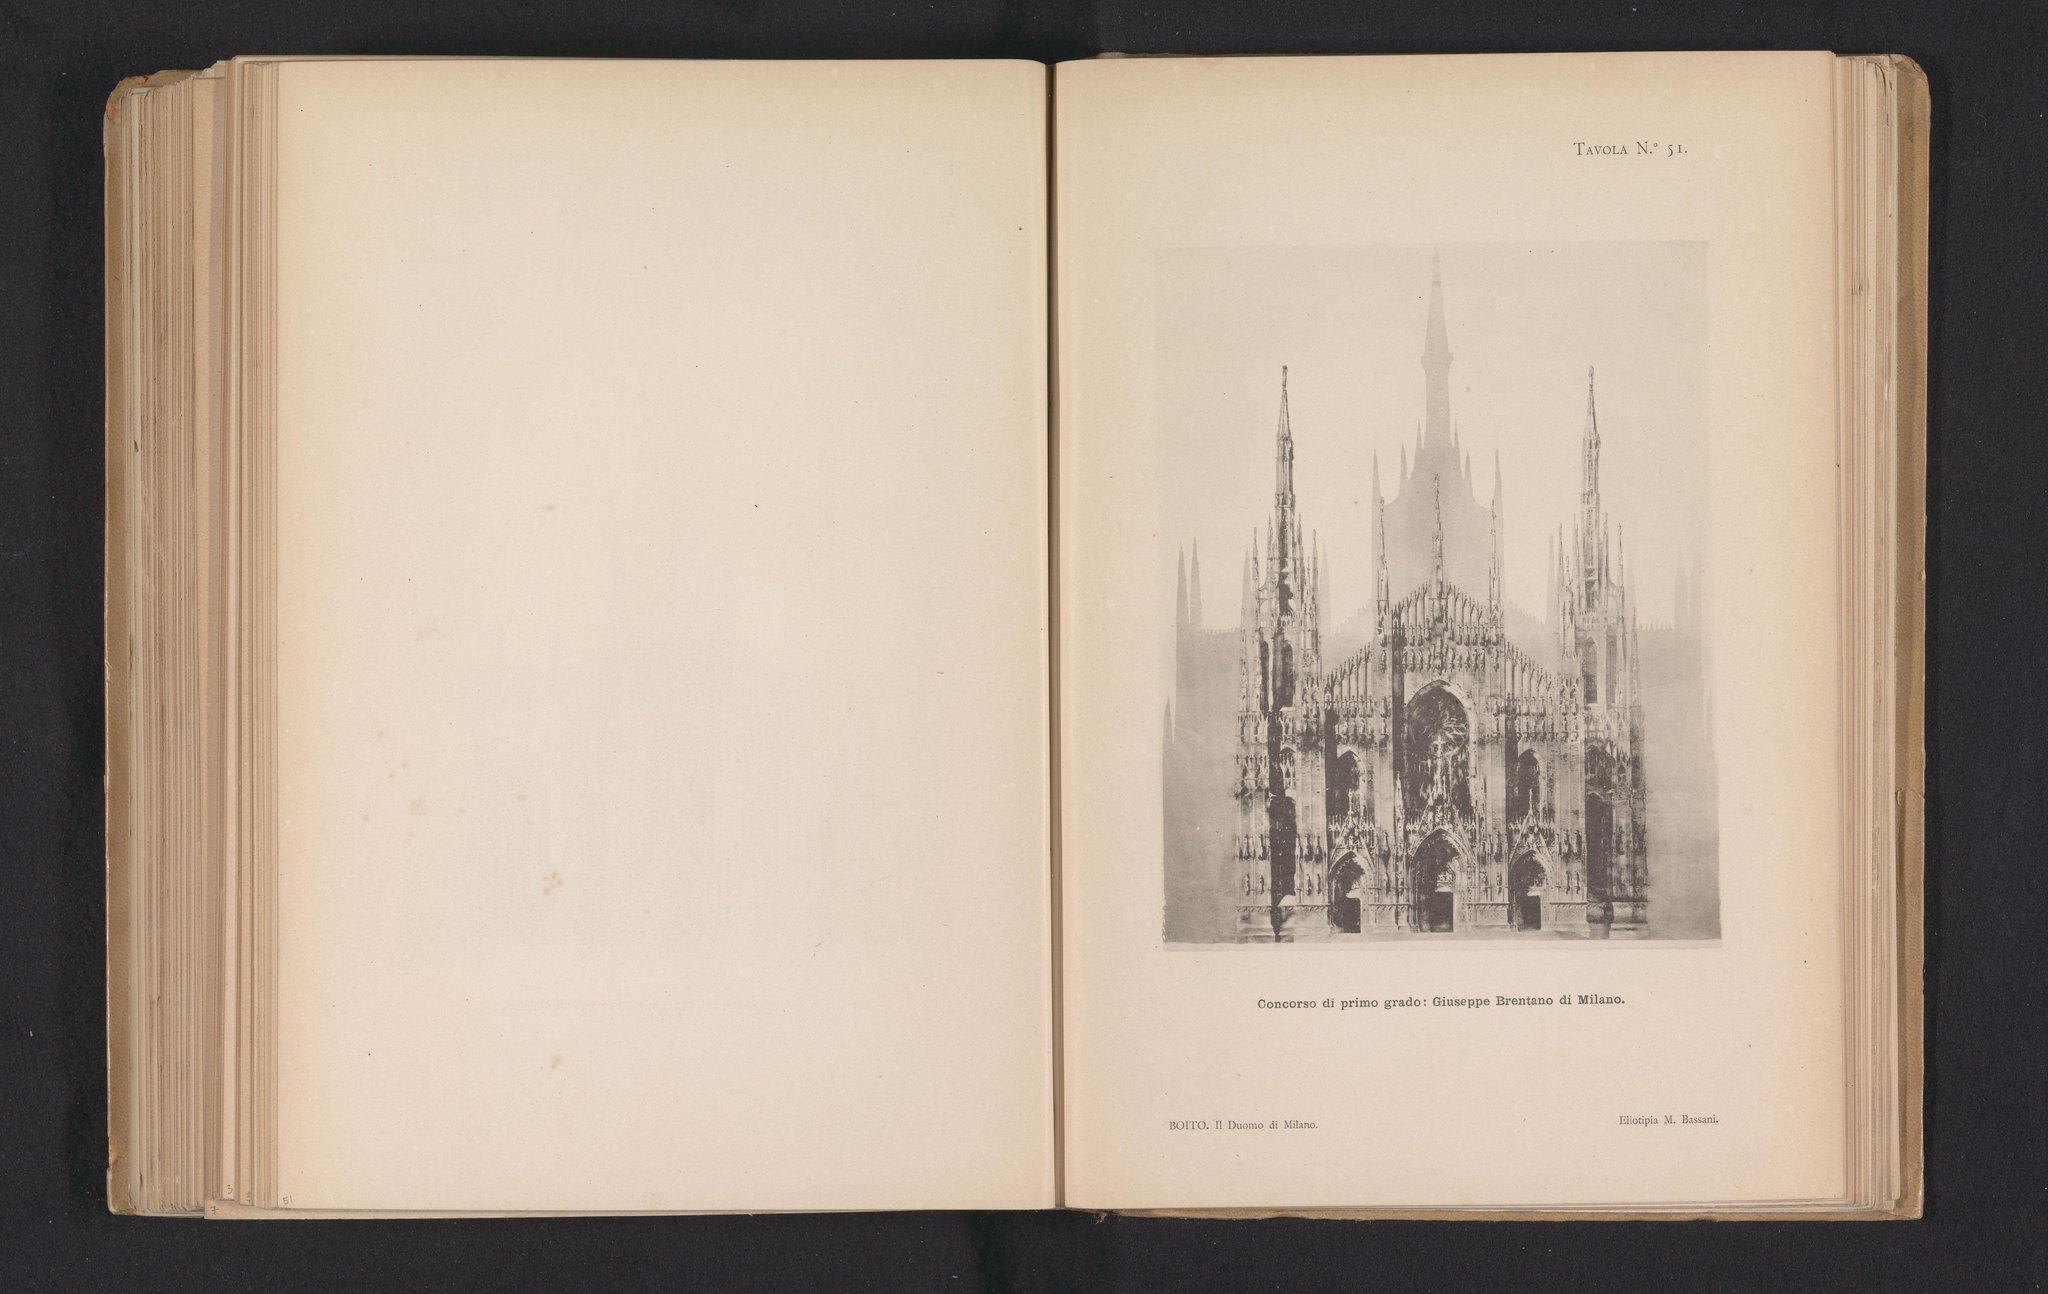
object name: reproduction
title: Fotoreproductie van een ontwerptekening van de façade van de Dom van Milaan door Giuseppe Brentano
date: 1886-1889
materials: paper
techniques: photograph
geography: milan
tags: drawing, sketch, parts of church exterior and annexes: façade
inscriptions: number: ‘Tavola No. 51.’